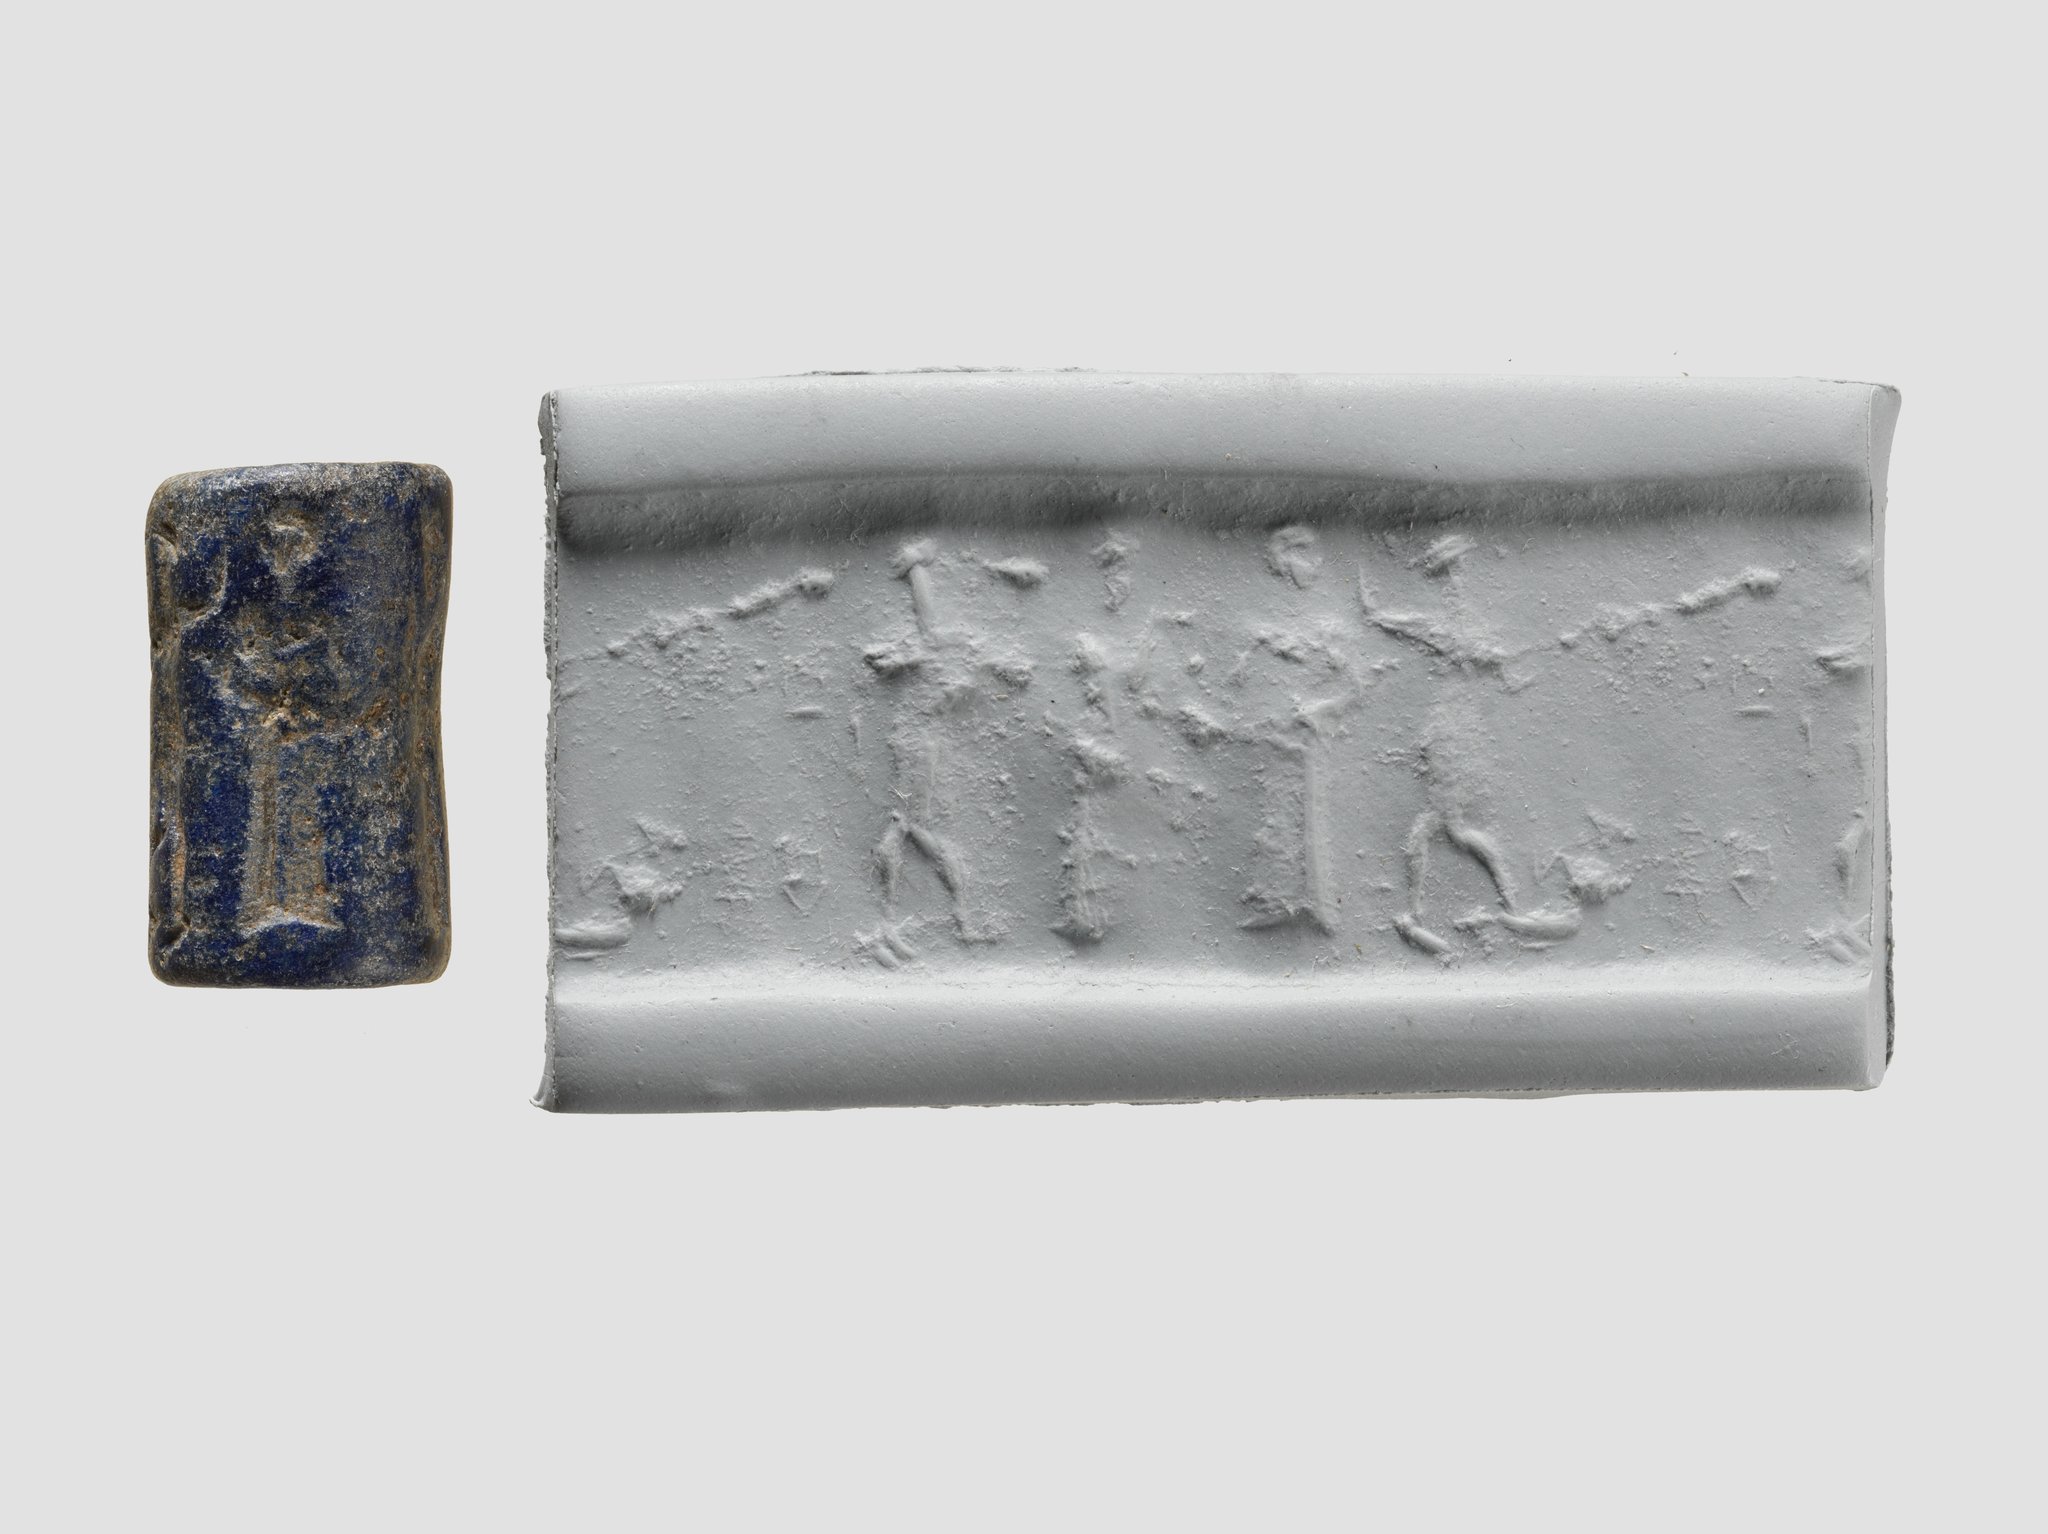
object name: cylinder seal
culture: babylonian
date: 1900-1501 BCE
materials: lapis lazuli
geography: mesopotamia